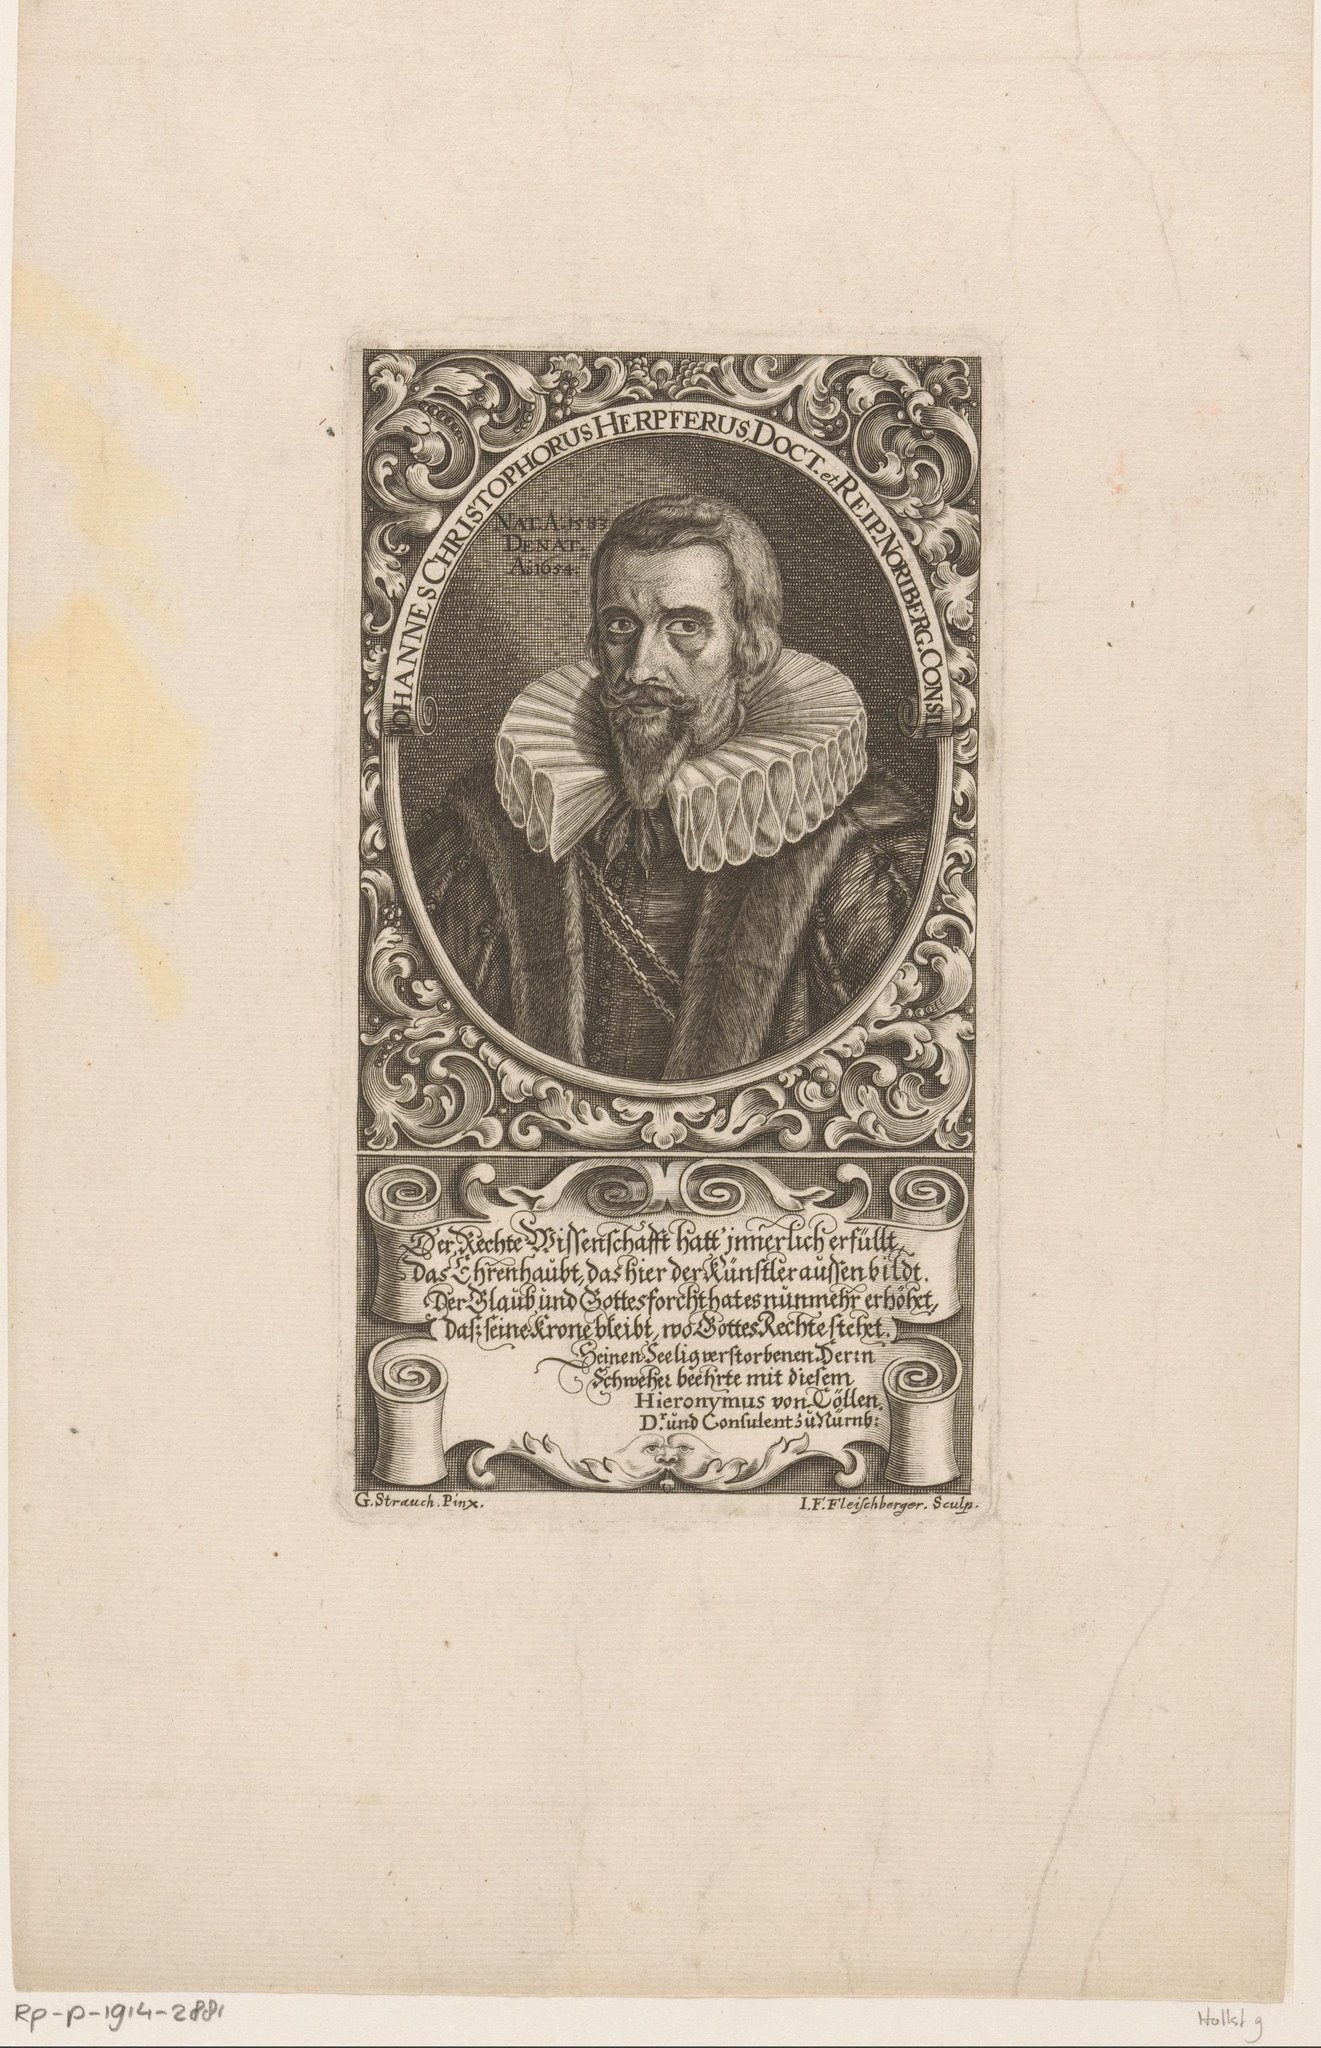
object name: print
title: Portret van Johann Christoph Herpfer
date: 1654-1665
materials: paper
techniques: engraving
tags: ornament ~ medallion, historical persons, ornament ~ cartouche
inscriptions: collector's mark: Lugt 2228